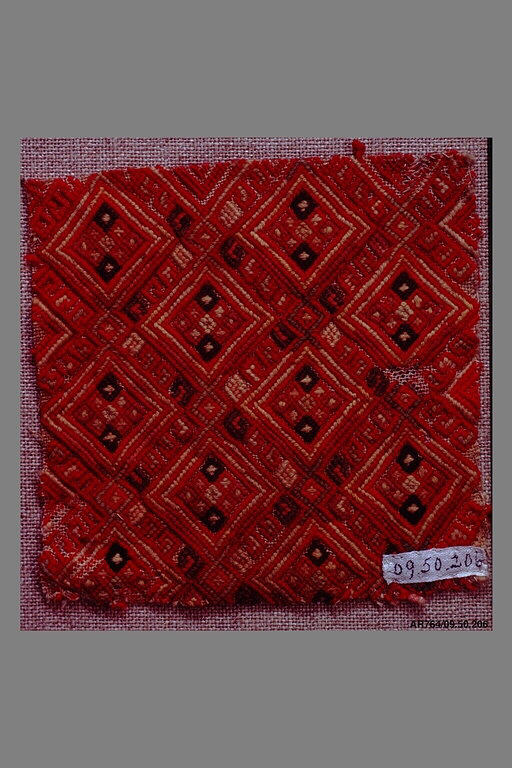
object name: costume fragment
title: Peasant costume fragment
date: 1701-1900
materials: canvas